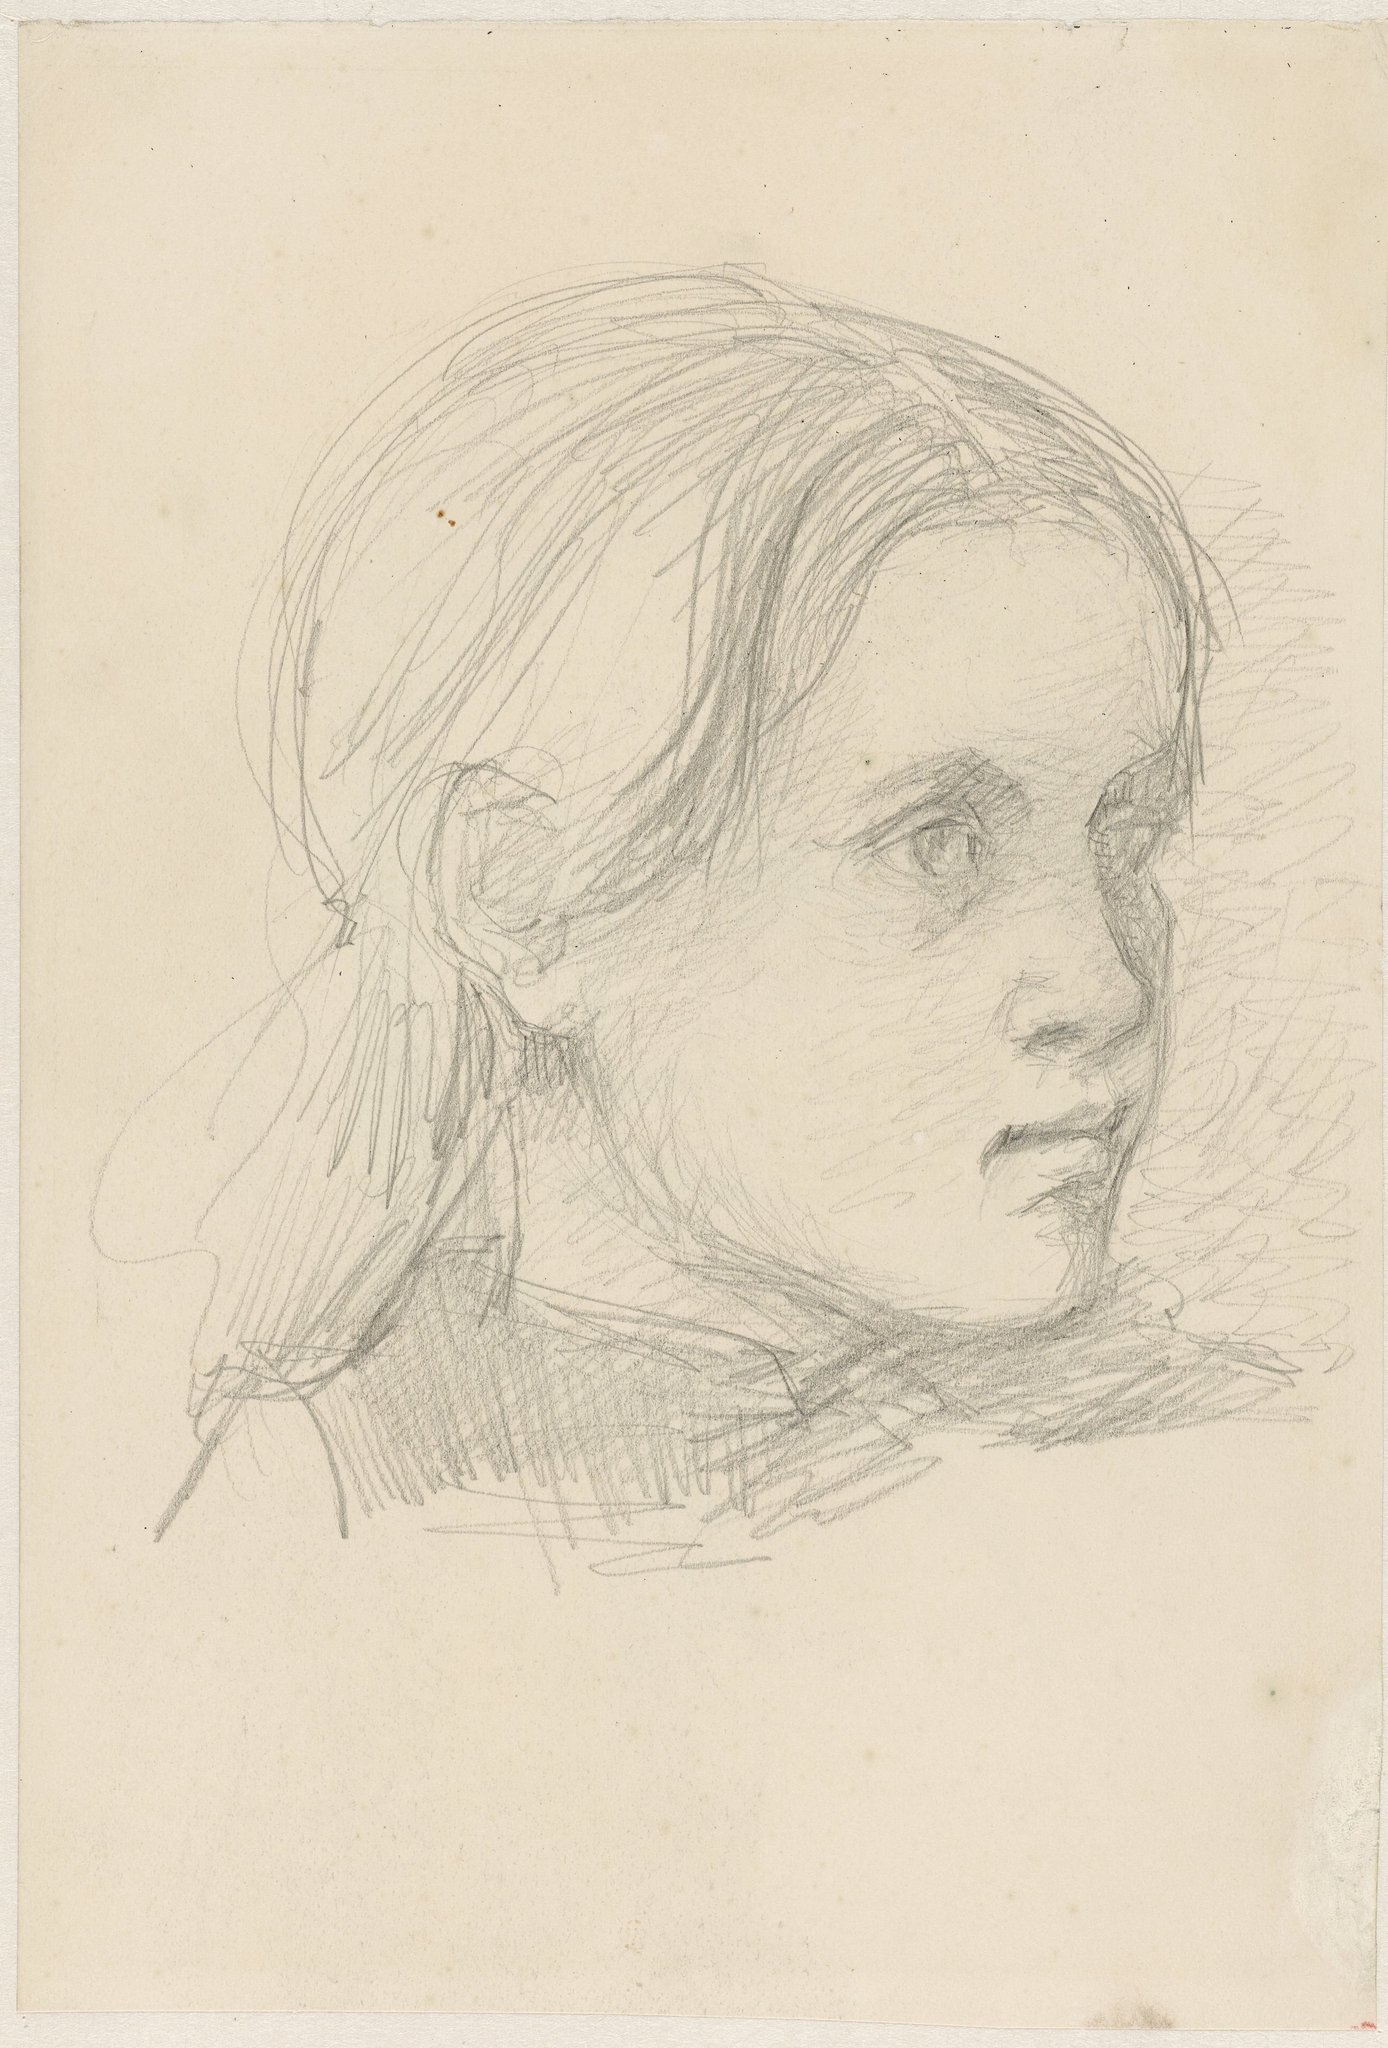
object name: drawing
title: Meisjeskopje, driekwart naar rechts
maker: jozef israëls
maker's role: draughtsman, painter, print maker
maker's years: 1824-1911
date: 1834-1911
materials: paper, pencil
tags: anonymous historical person portrayed alone